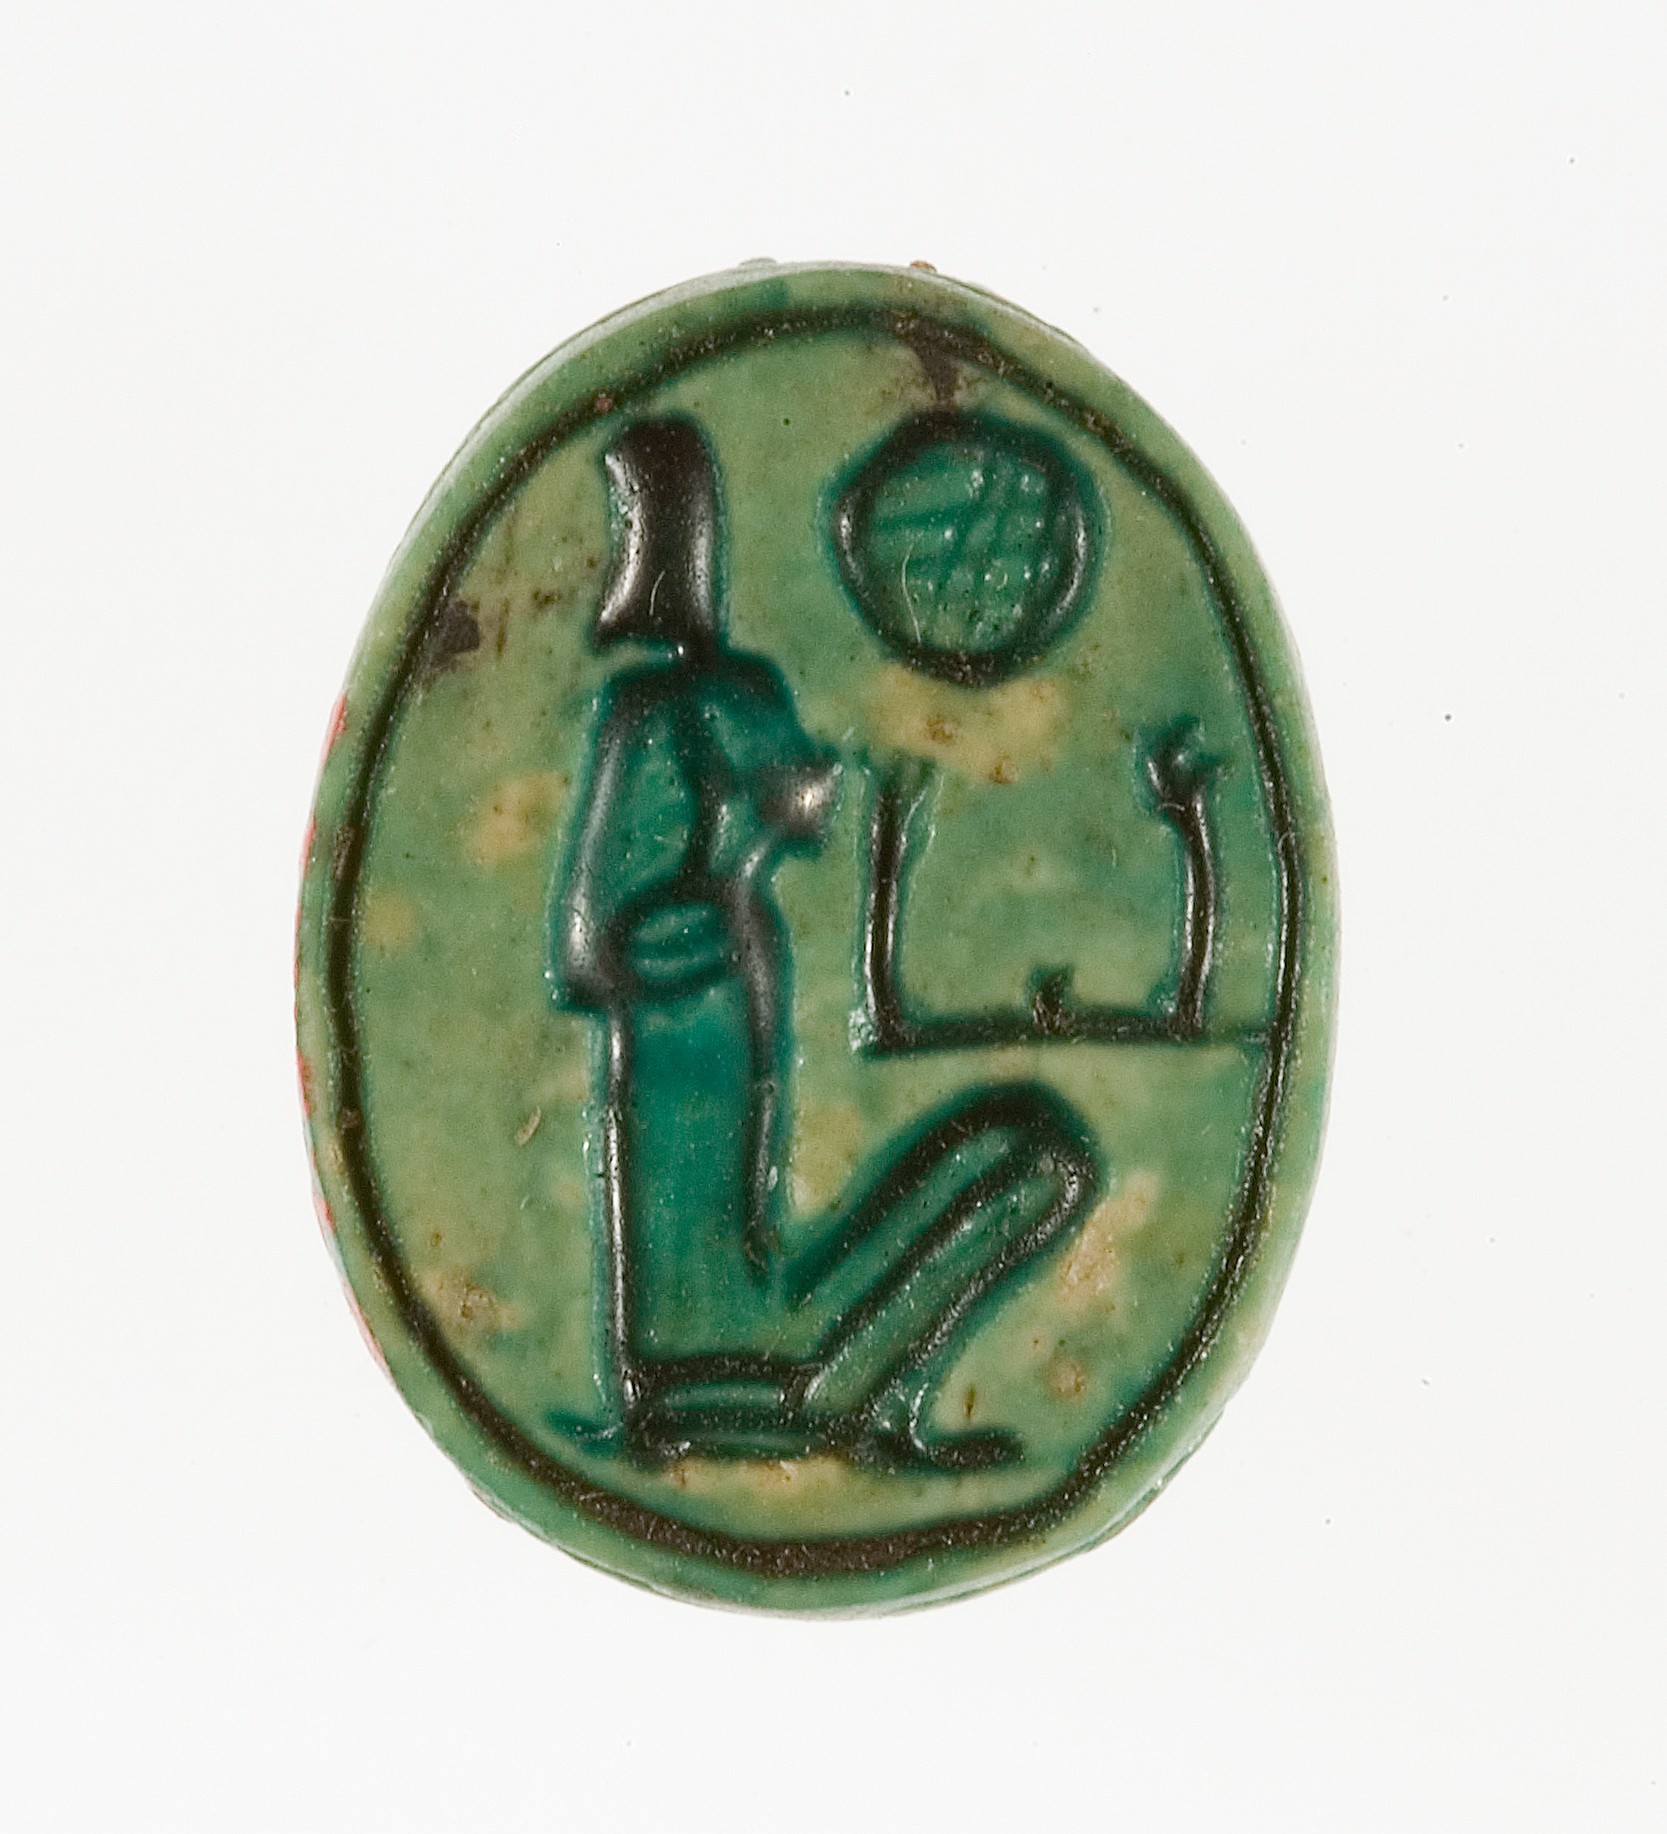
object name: scarab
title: Scarab Inscribed with the Name Maatkare (Hatshepsut)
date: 1479-1458 BCE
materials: stone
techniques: glazing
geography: egypt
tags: scarabs